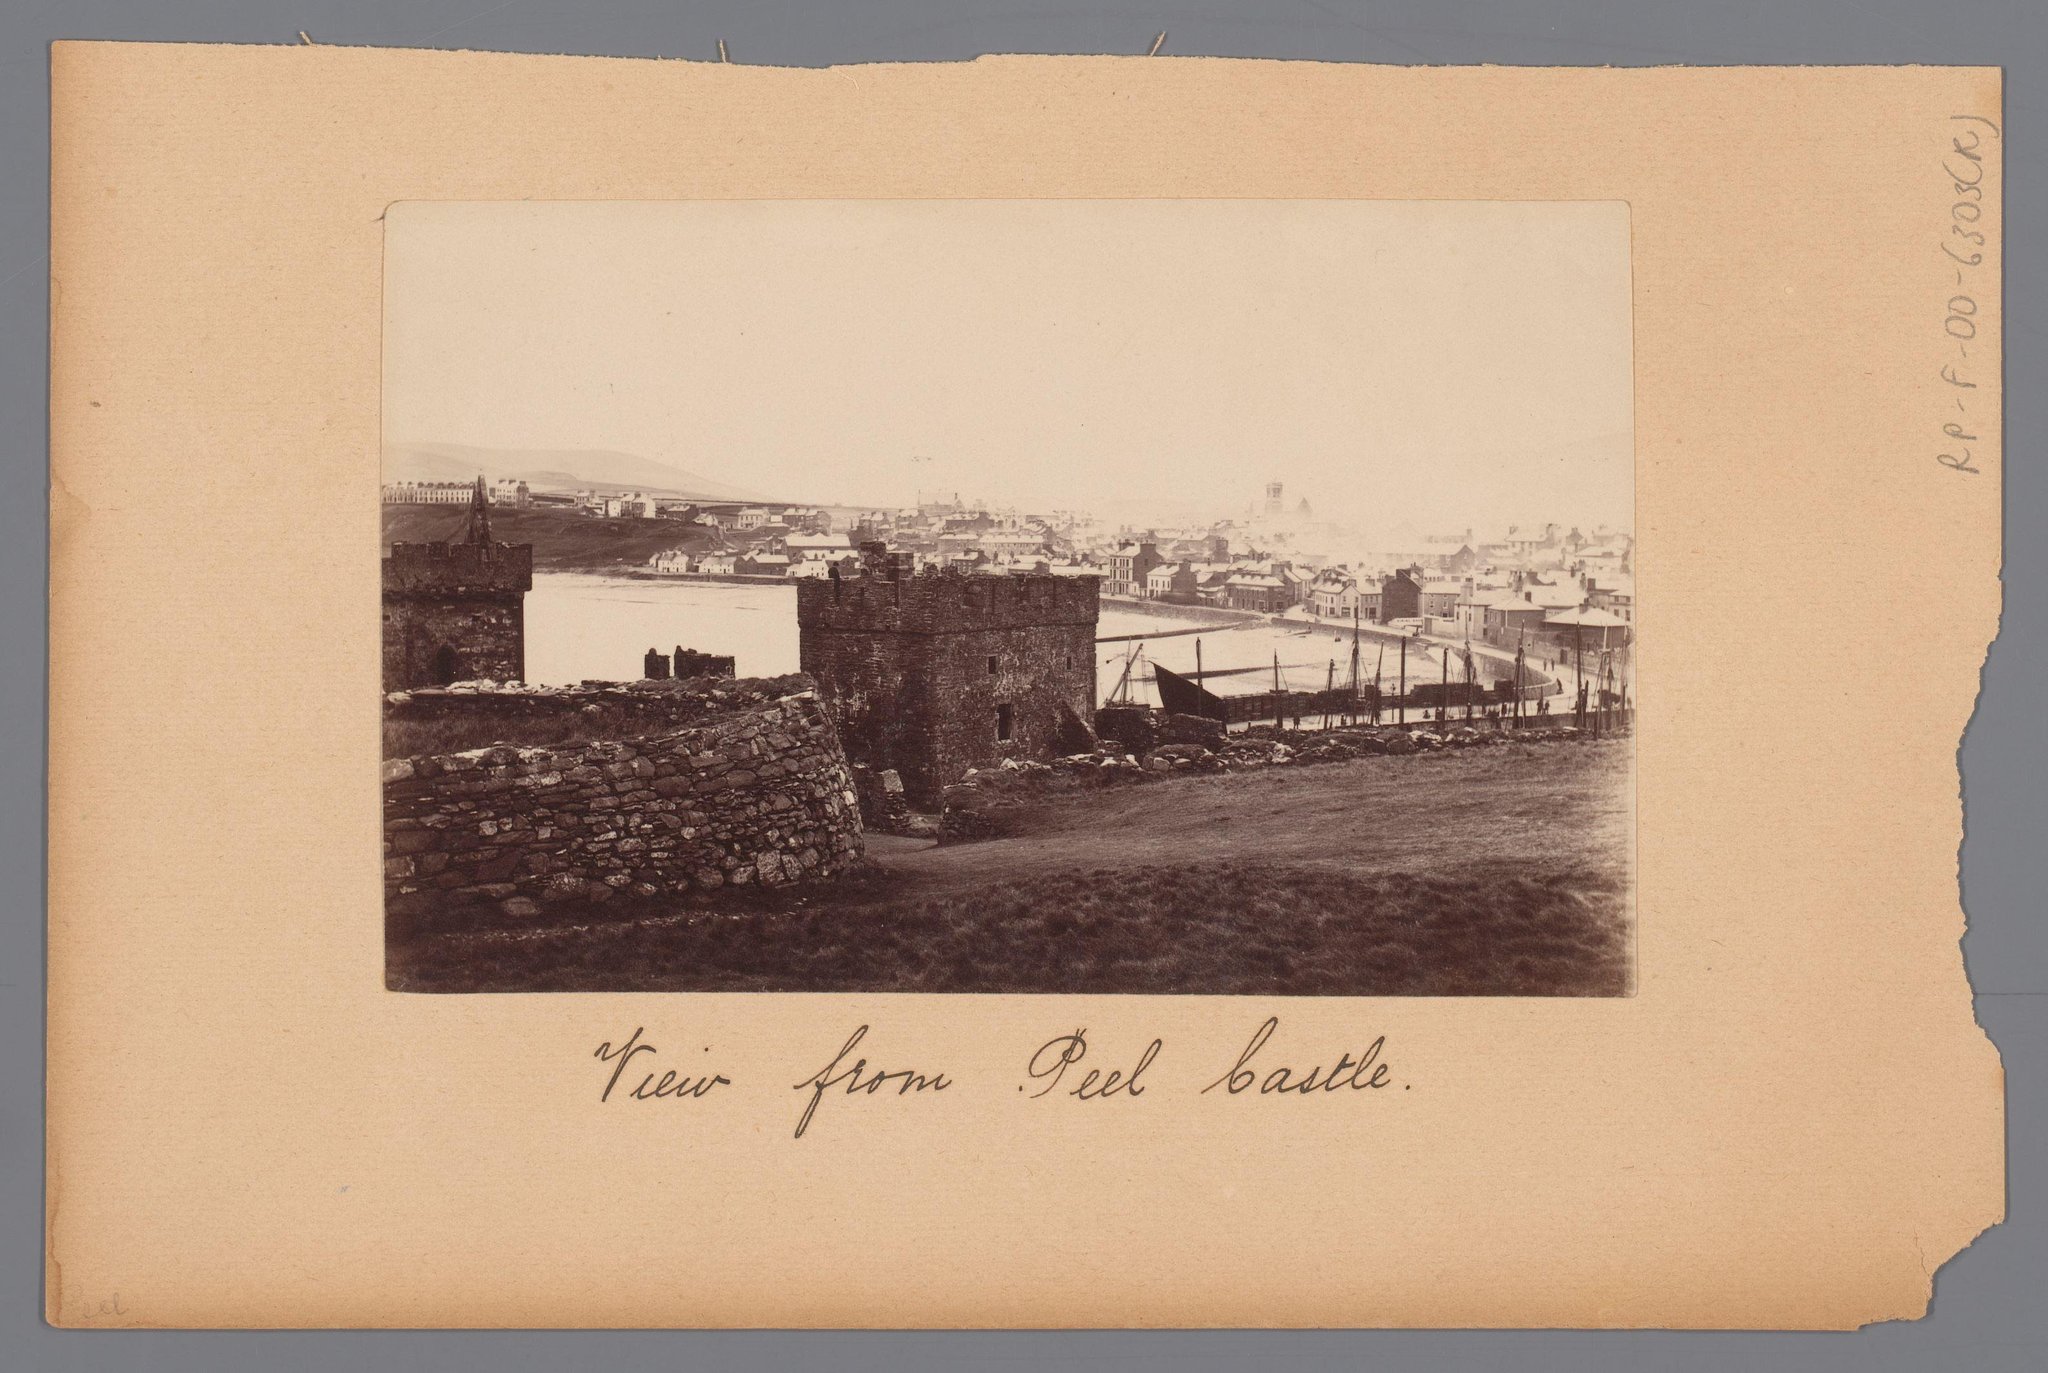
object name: photograph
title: Uitzicht vanuit Peel Castle, Isle of Man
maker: Anonymous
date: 1880-1900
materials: cardboard, paper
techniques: albumen print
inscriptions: caption: ‘View form Peel Castle’, inscription: ‘Peel’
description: Uitzicht vanuit Peel Castle, op een gedeelte van het kasteel, over een meer en op de stad Peel, Isle of Man.